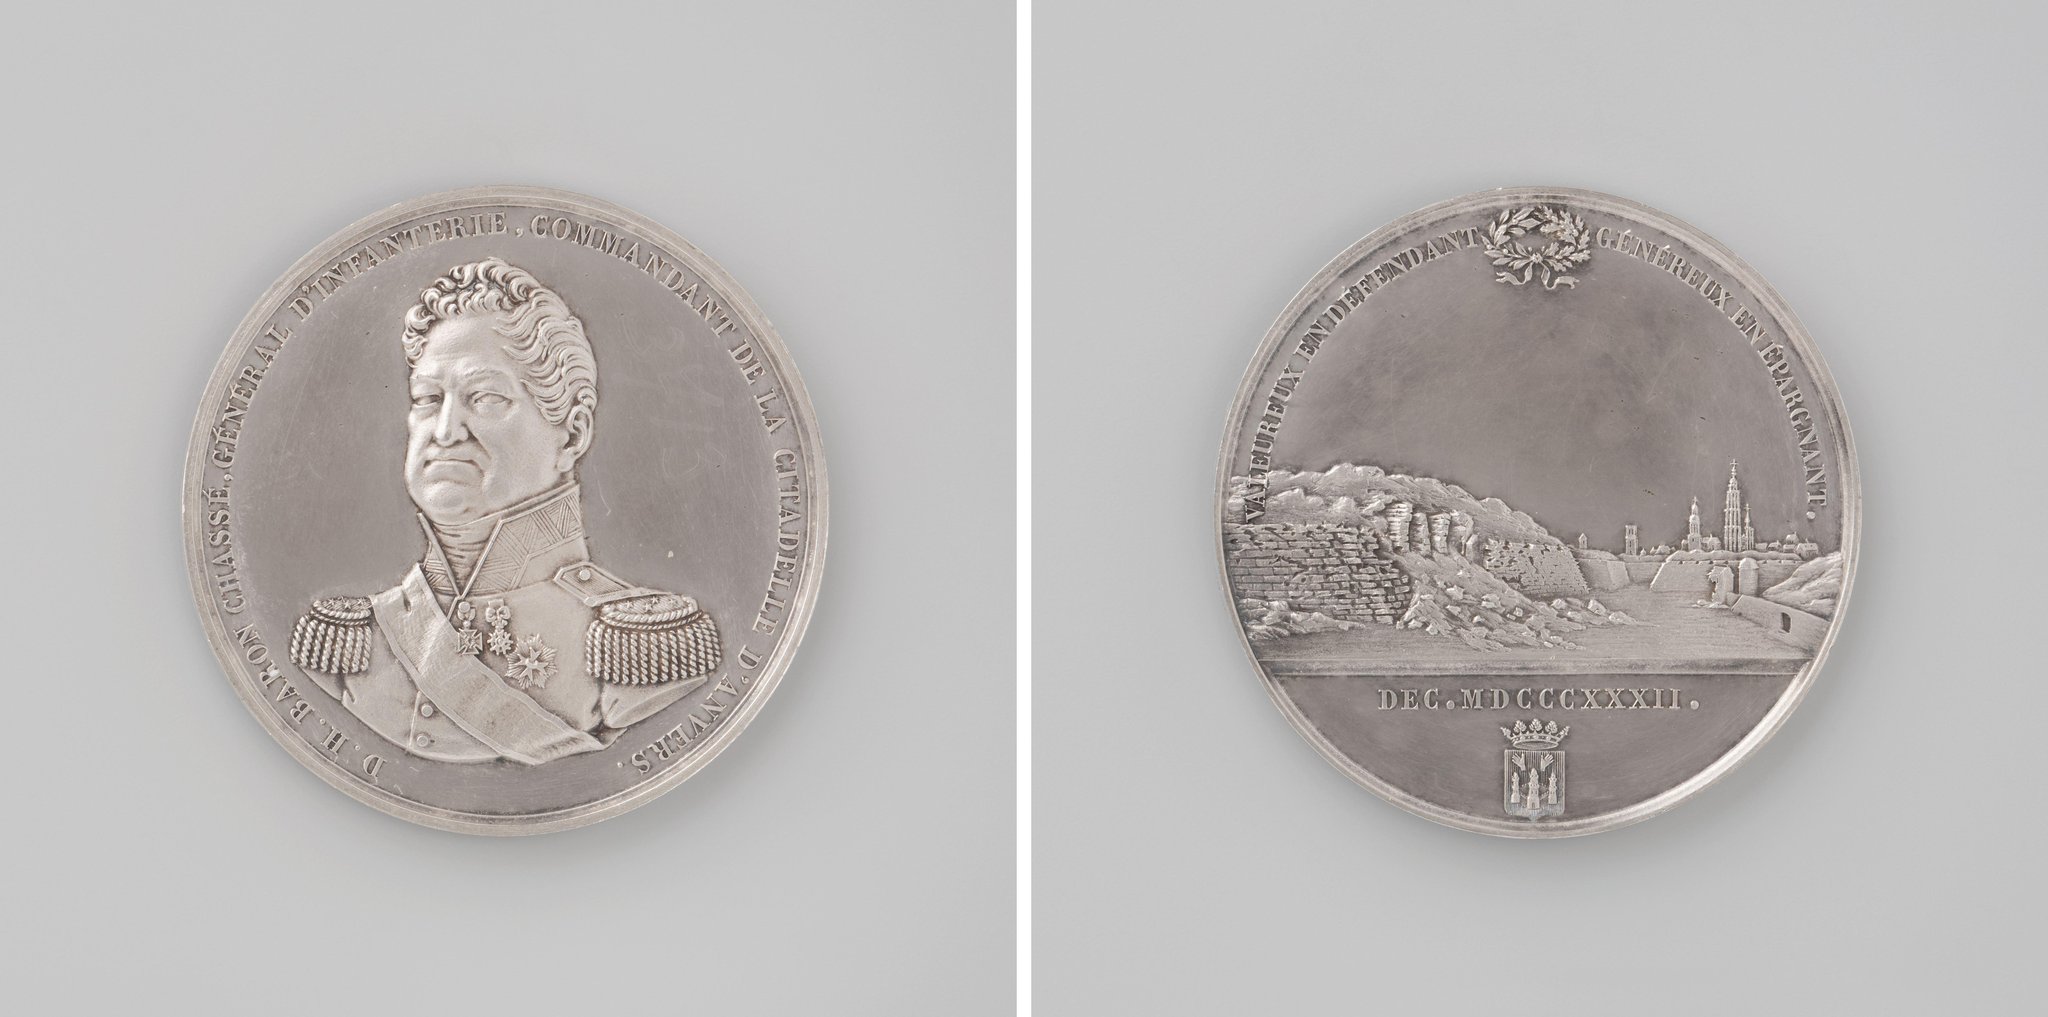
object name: history medal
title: Verdediging van de citadel van Antwerpen, ter ere van Chasse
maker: Anonymous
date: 1832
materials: silver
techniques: striking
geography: antwerp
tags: david hendrik baron chassé, antwerp